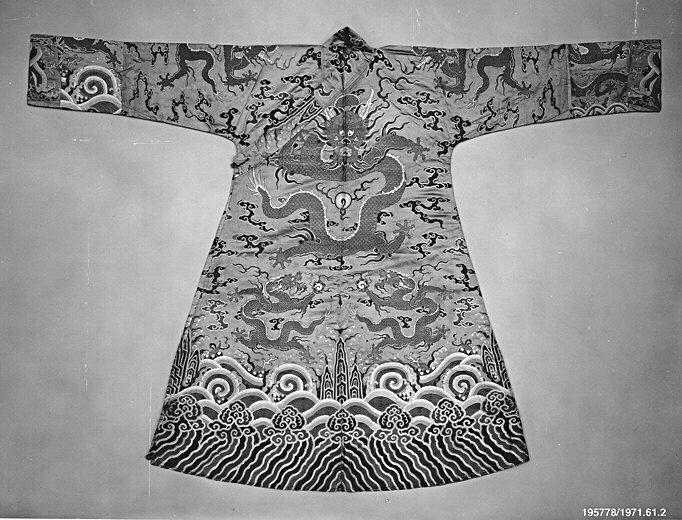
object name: robe, lay aristocrat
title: Robe for Lay Aristocrat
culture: tibetan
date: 1901-1933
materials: metal thread, silk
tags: dragons